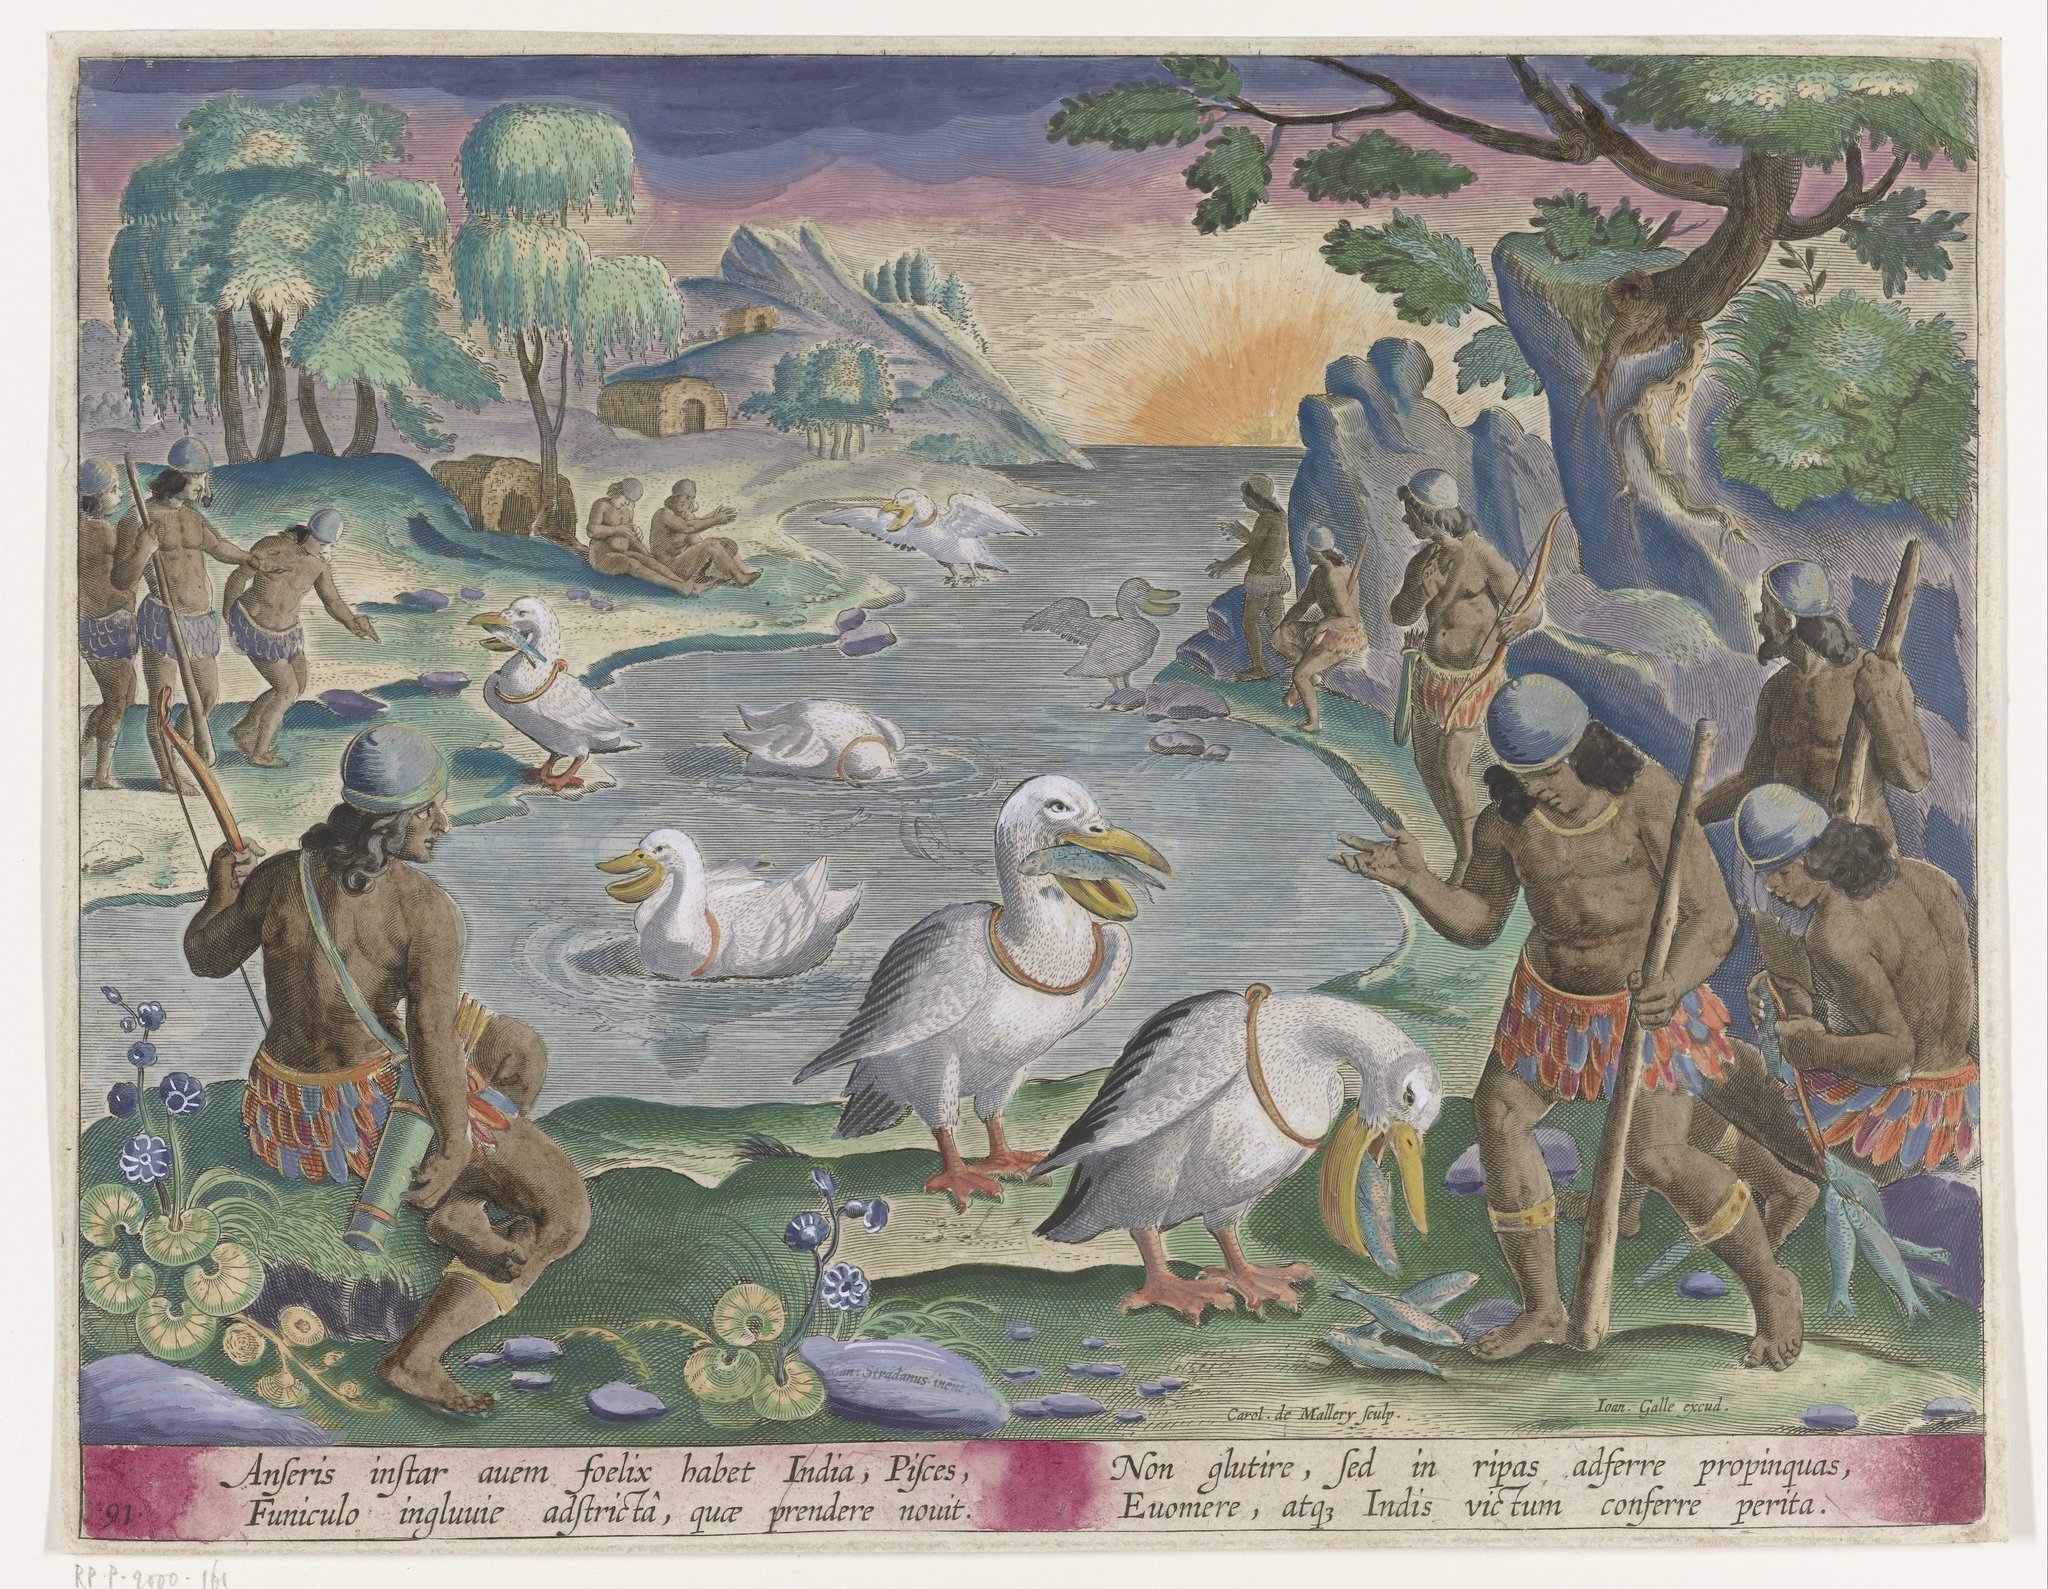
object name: print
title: Jachttaferelen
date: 1634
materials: paper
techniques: engraving, hand coloring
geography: florence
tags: game, hunted animals (+ hunting with birds), native peoples of the americas, water-birds: pelican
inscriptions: collector's mark: Lugt 2760, collector's mark: Lugt 2228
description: Oorspronkelijke bewoners van Amerika, gekleed in veren rokken, gewapend met pijl-en-boog en stok, zijn verzameld langs een rivieroever. In de rivier zwemmen pelikanen die vissen vangen en deze naar de kant brengen. Zonsondergang of -opgang aan de horizon. De prent heeft een Latijns onderschrift en is deel van een serie van jachttaferelen.